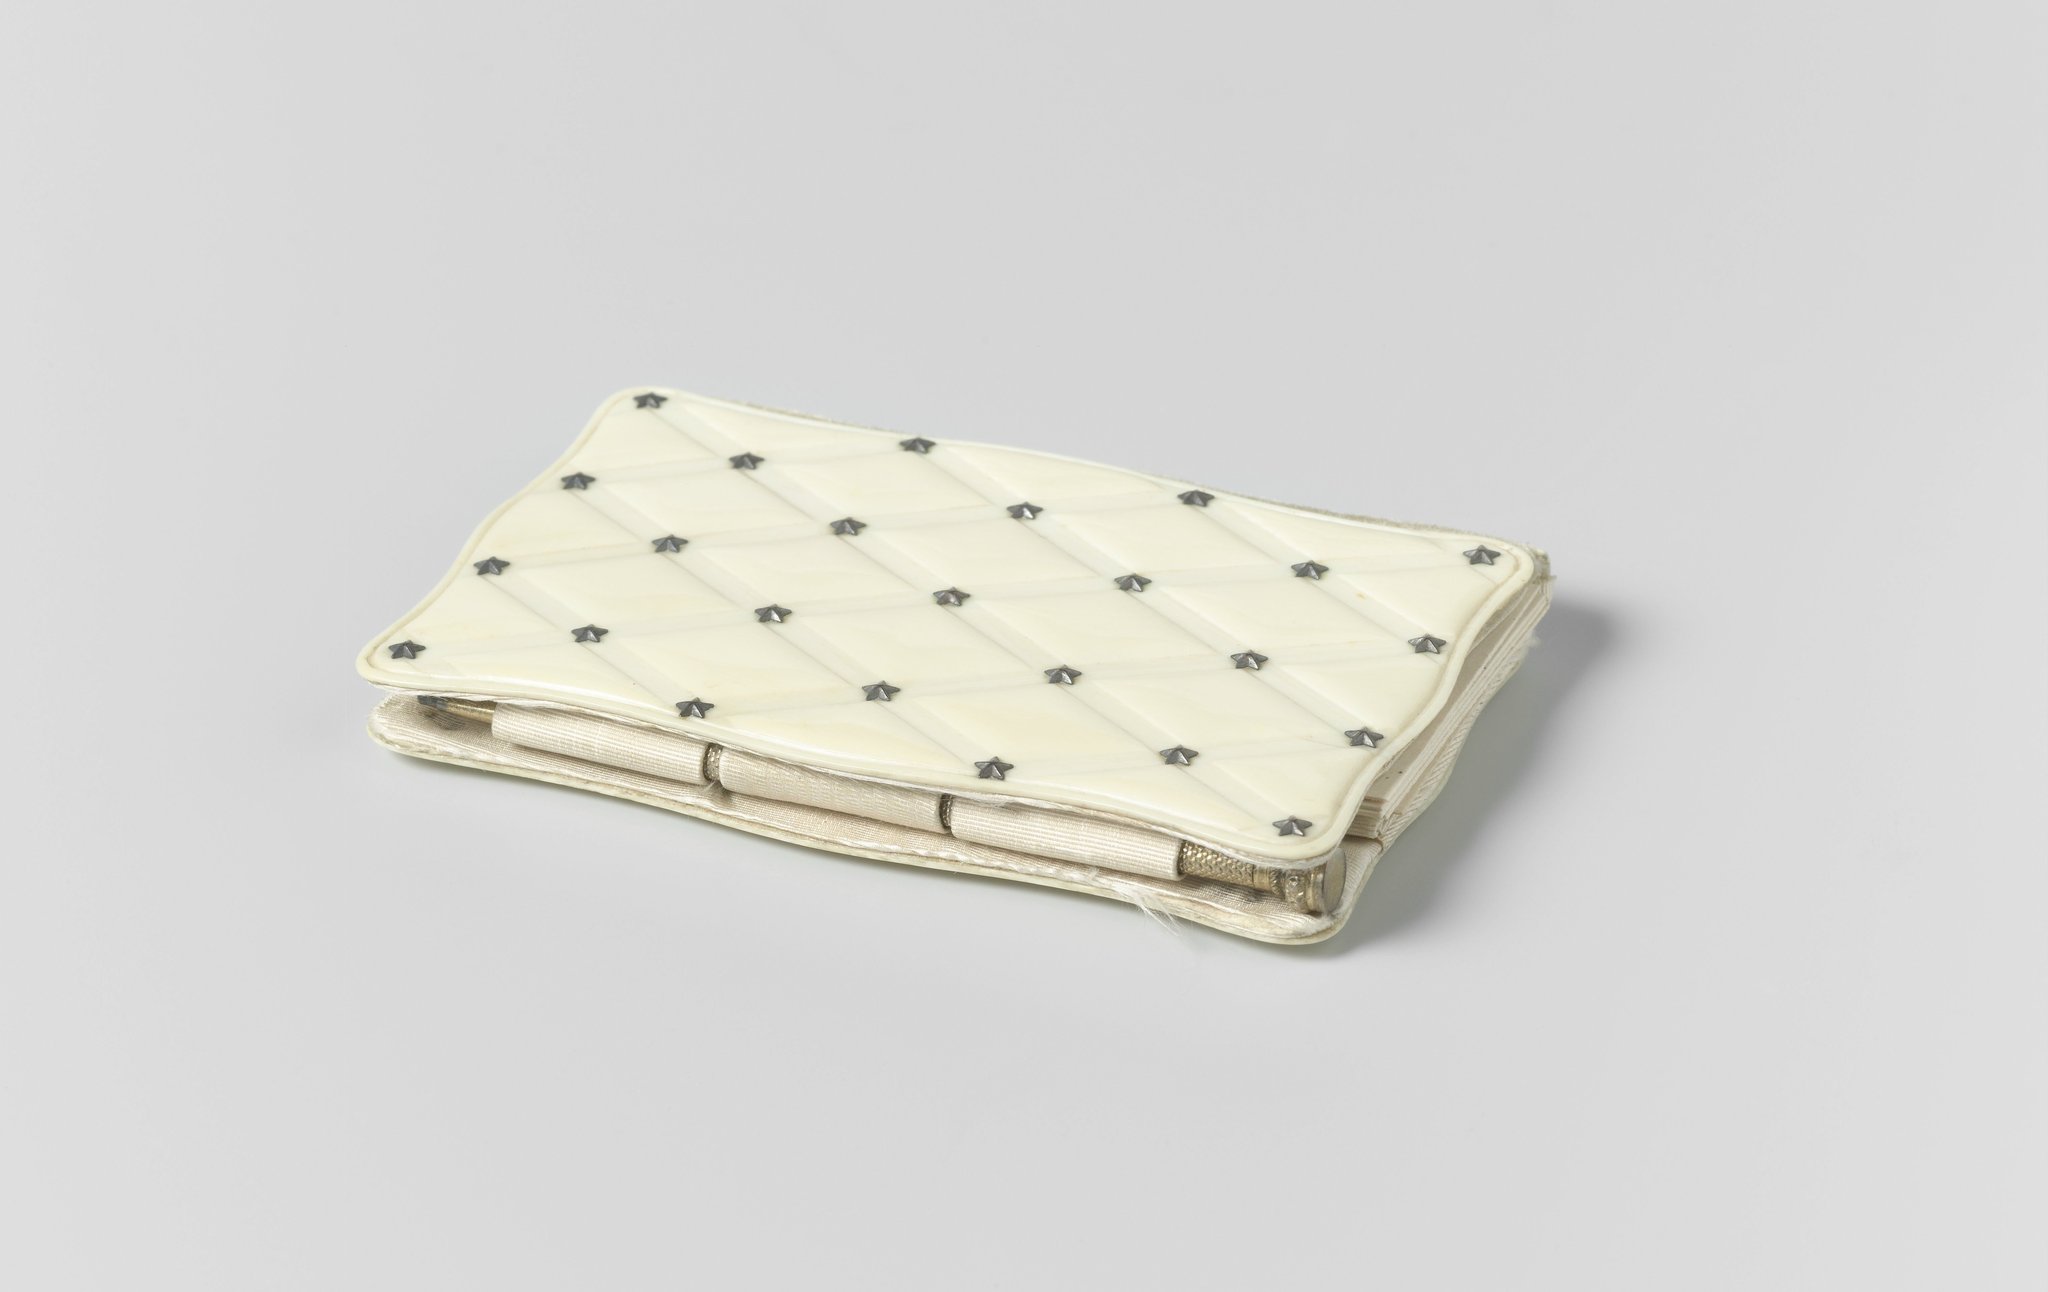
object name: visiting card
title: Visitekaarthouder van ivoor, met gewelfde randen en ruitvormig reliëf, met in iedere kruising een metalen ster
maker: Anonymous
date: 1890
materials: ivory, metal, paper, silk, velvet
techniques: cutting, weave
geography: netherlands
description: Visitekaartenboek van ivoor, met gewelfde randen en ruitvormig reliëf, met in iedere kruising een metalen ster. Sluiting middels een metalen potlood in de zijkant, gevoerd met roomkleurig gewaterde zijde. Gedeeltelijk fluwelen rug. Binnenin nog enkele visitekaartjes waarop: 'De heer en Mevrouw van der Waals-Jonker' en een waarop: 'Corrie Jonker' .